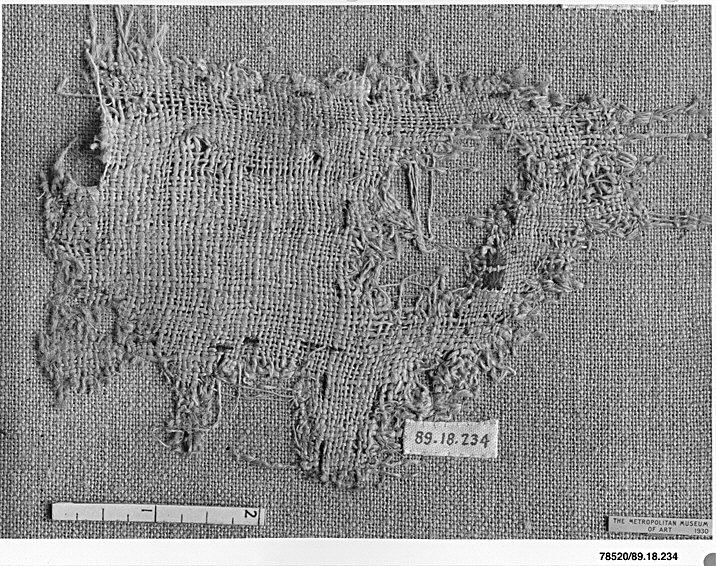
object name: textile fragment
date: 401-600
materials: linen, wool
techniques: weave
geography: egypt